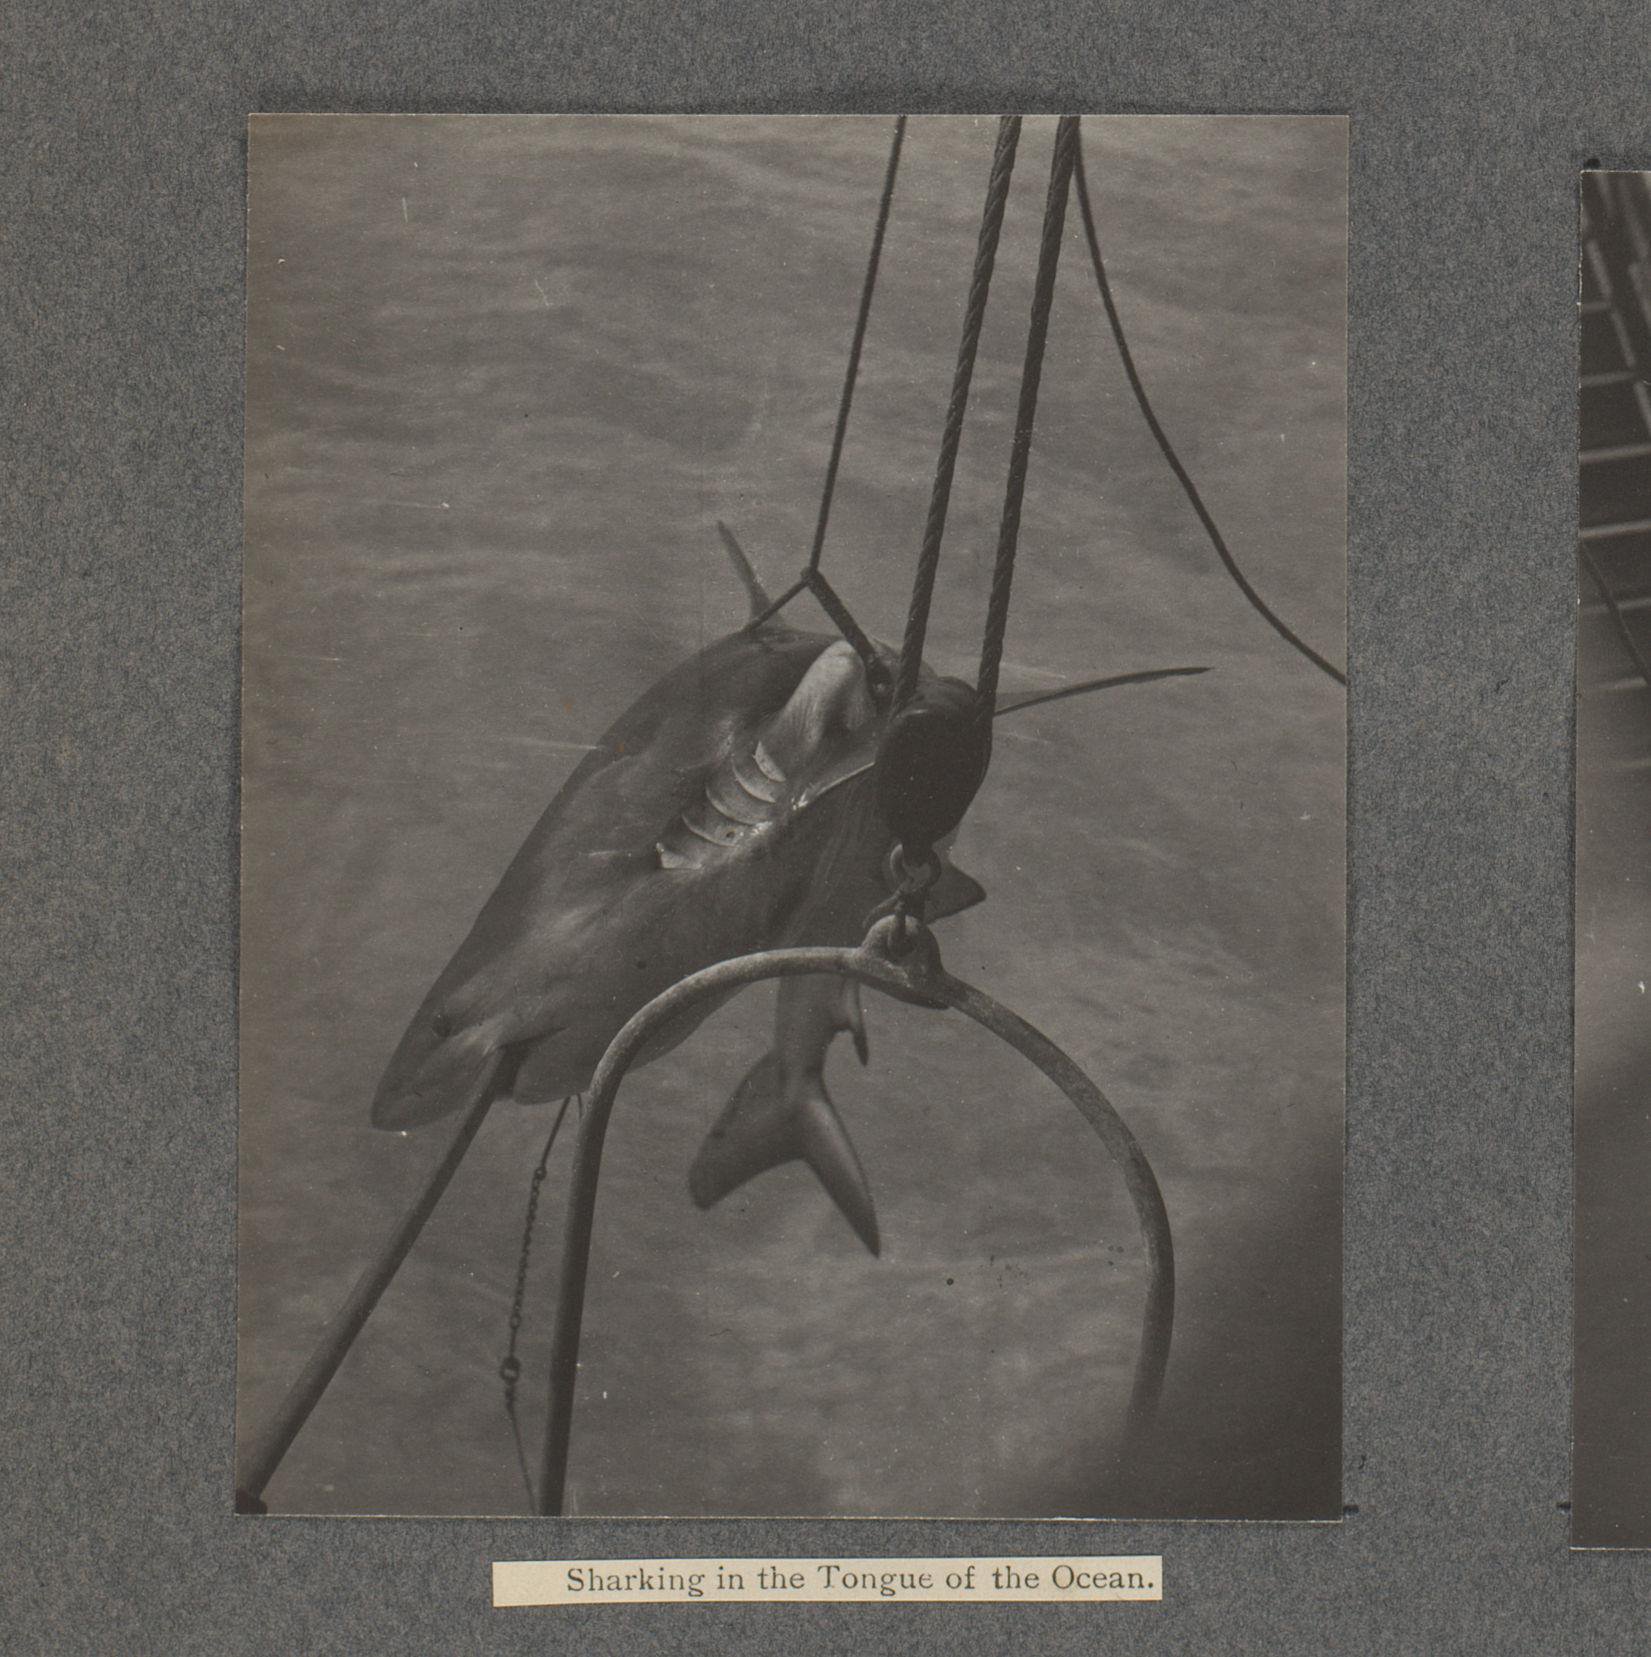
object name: album leaf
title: Gevangen haai wordt aan boord getakeld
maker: Anonymous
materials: paper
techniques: platinum process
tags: fishing (sports), cartilaginous fishes: shark, man killing animal